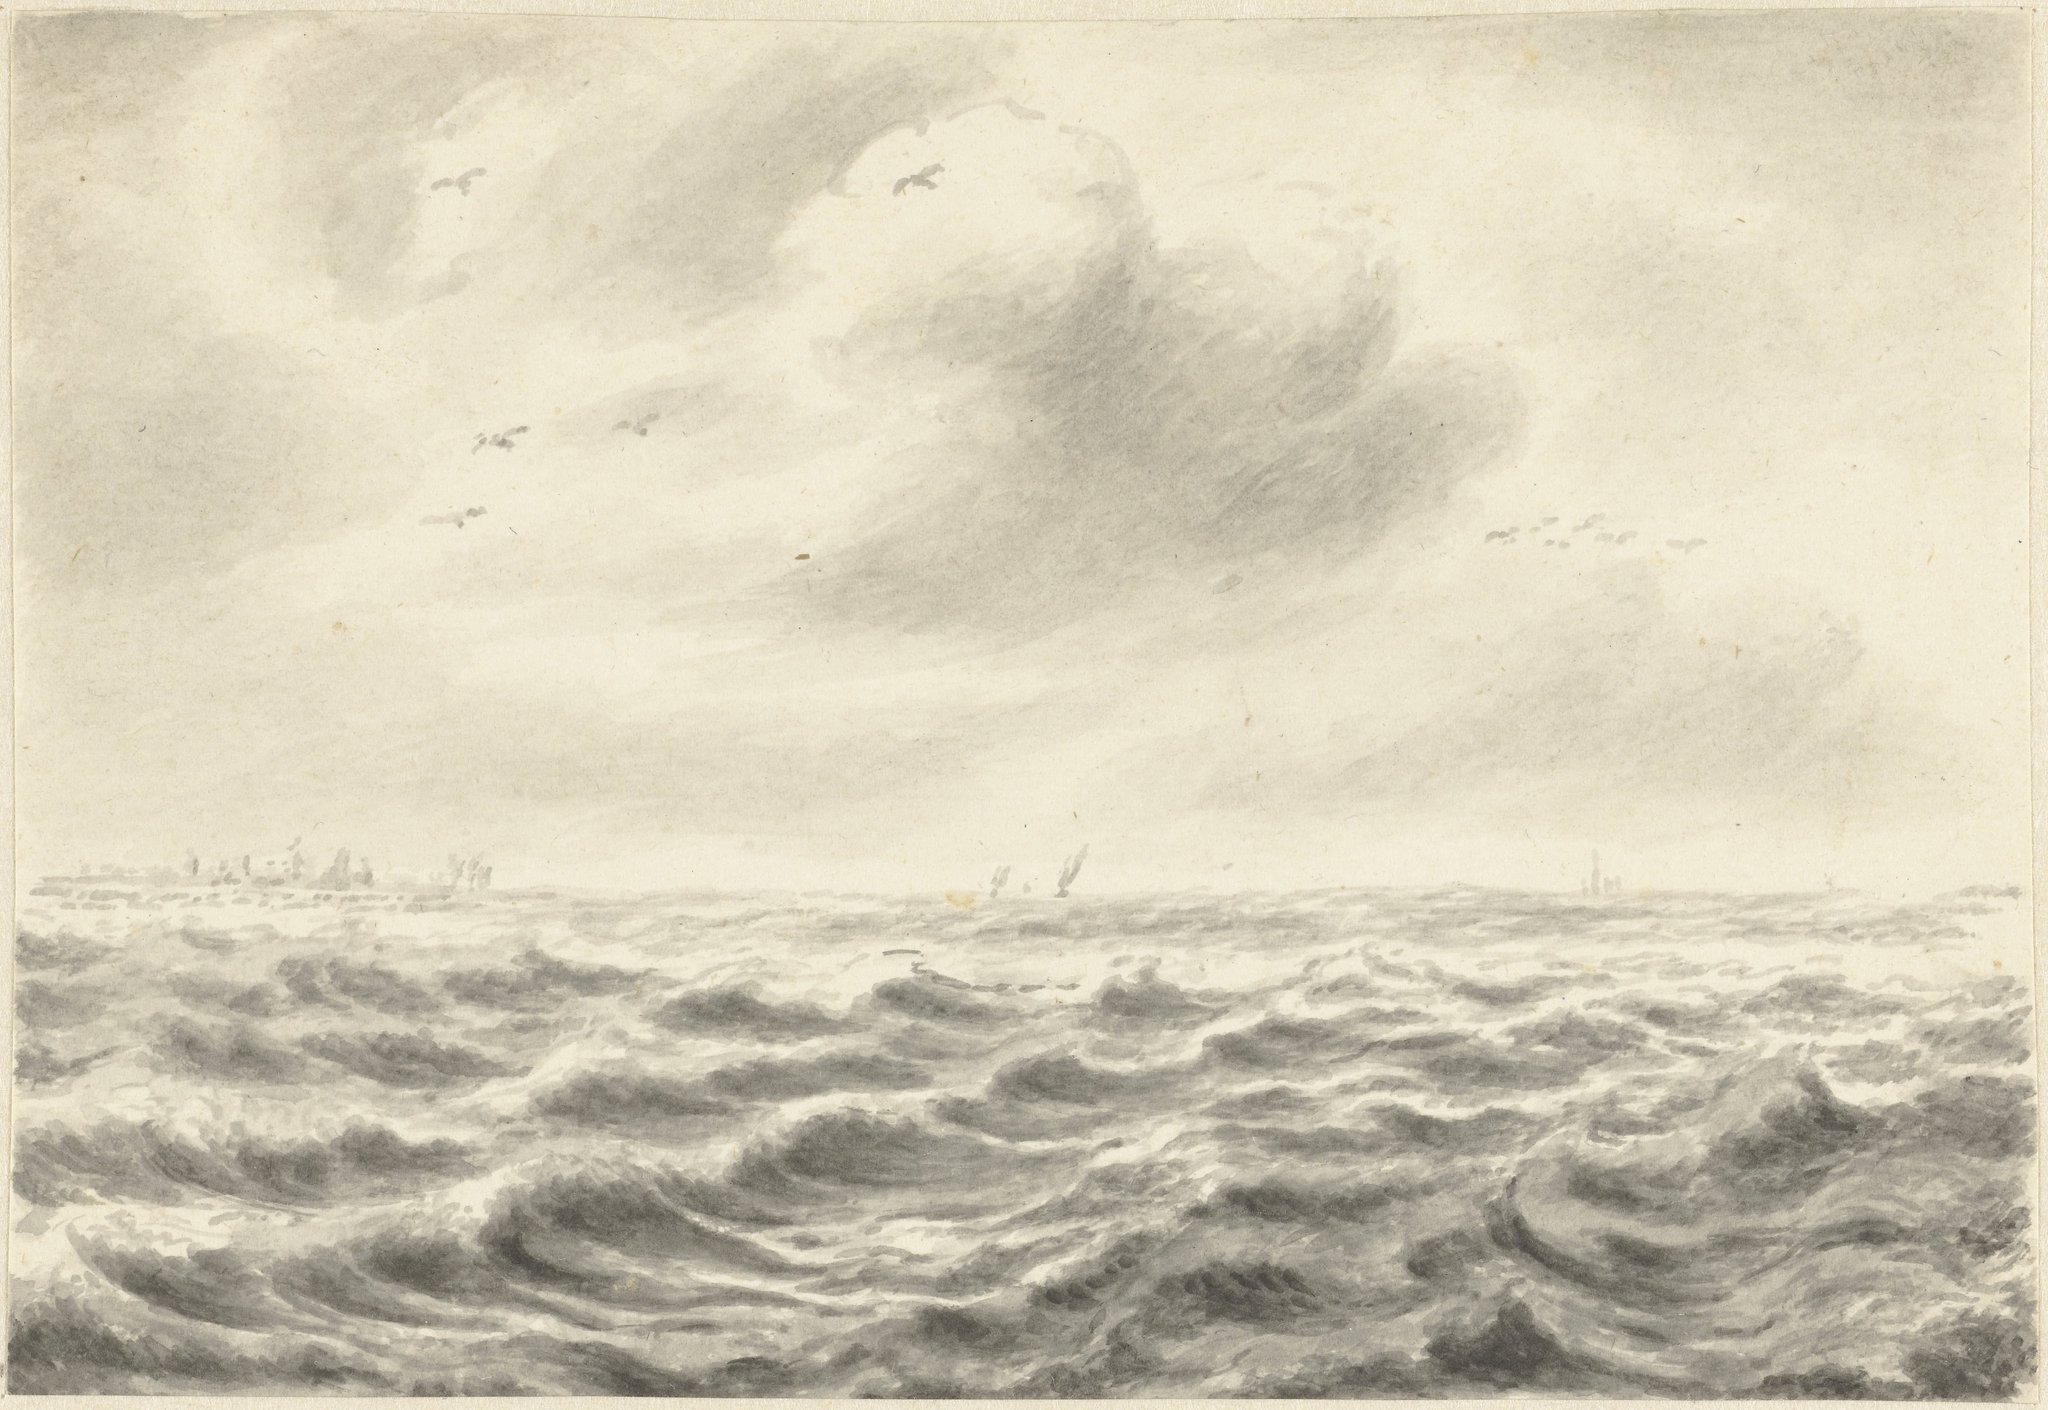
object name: drawing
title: Zeegezicht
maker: pieter idserts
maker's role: draughtsman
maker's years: 1698-1781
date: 1708-1781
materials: paper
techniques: brush